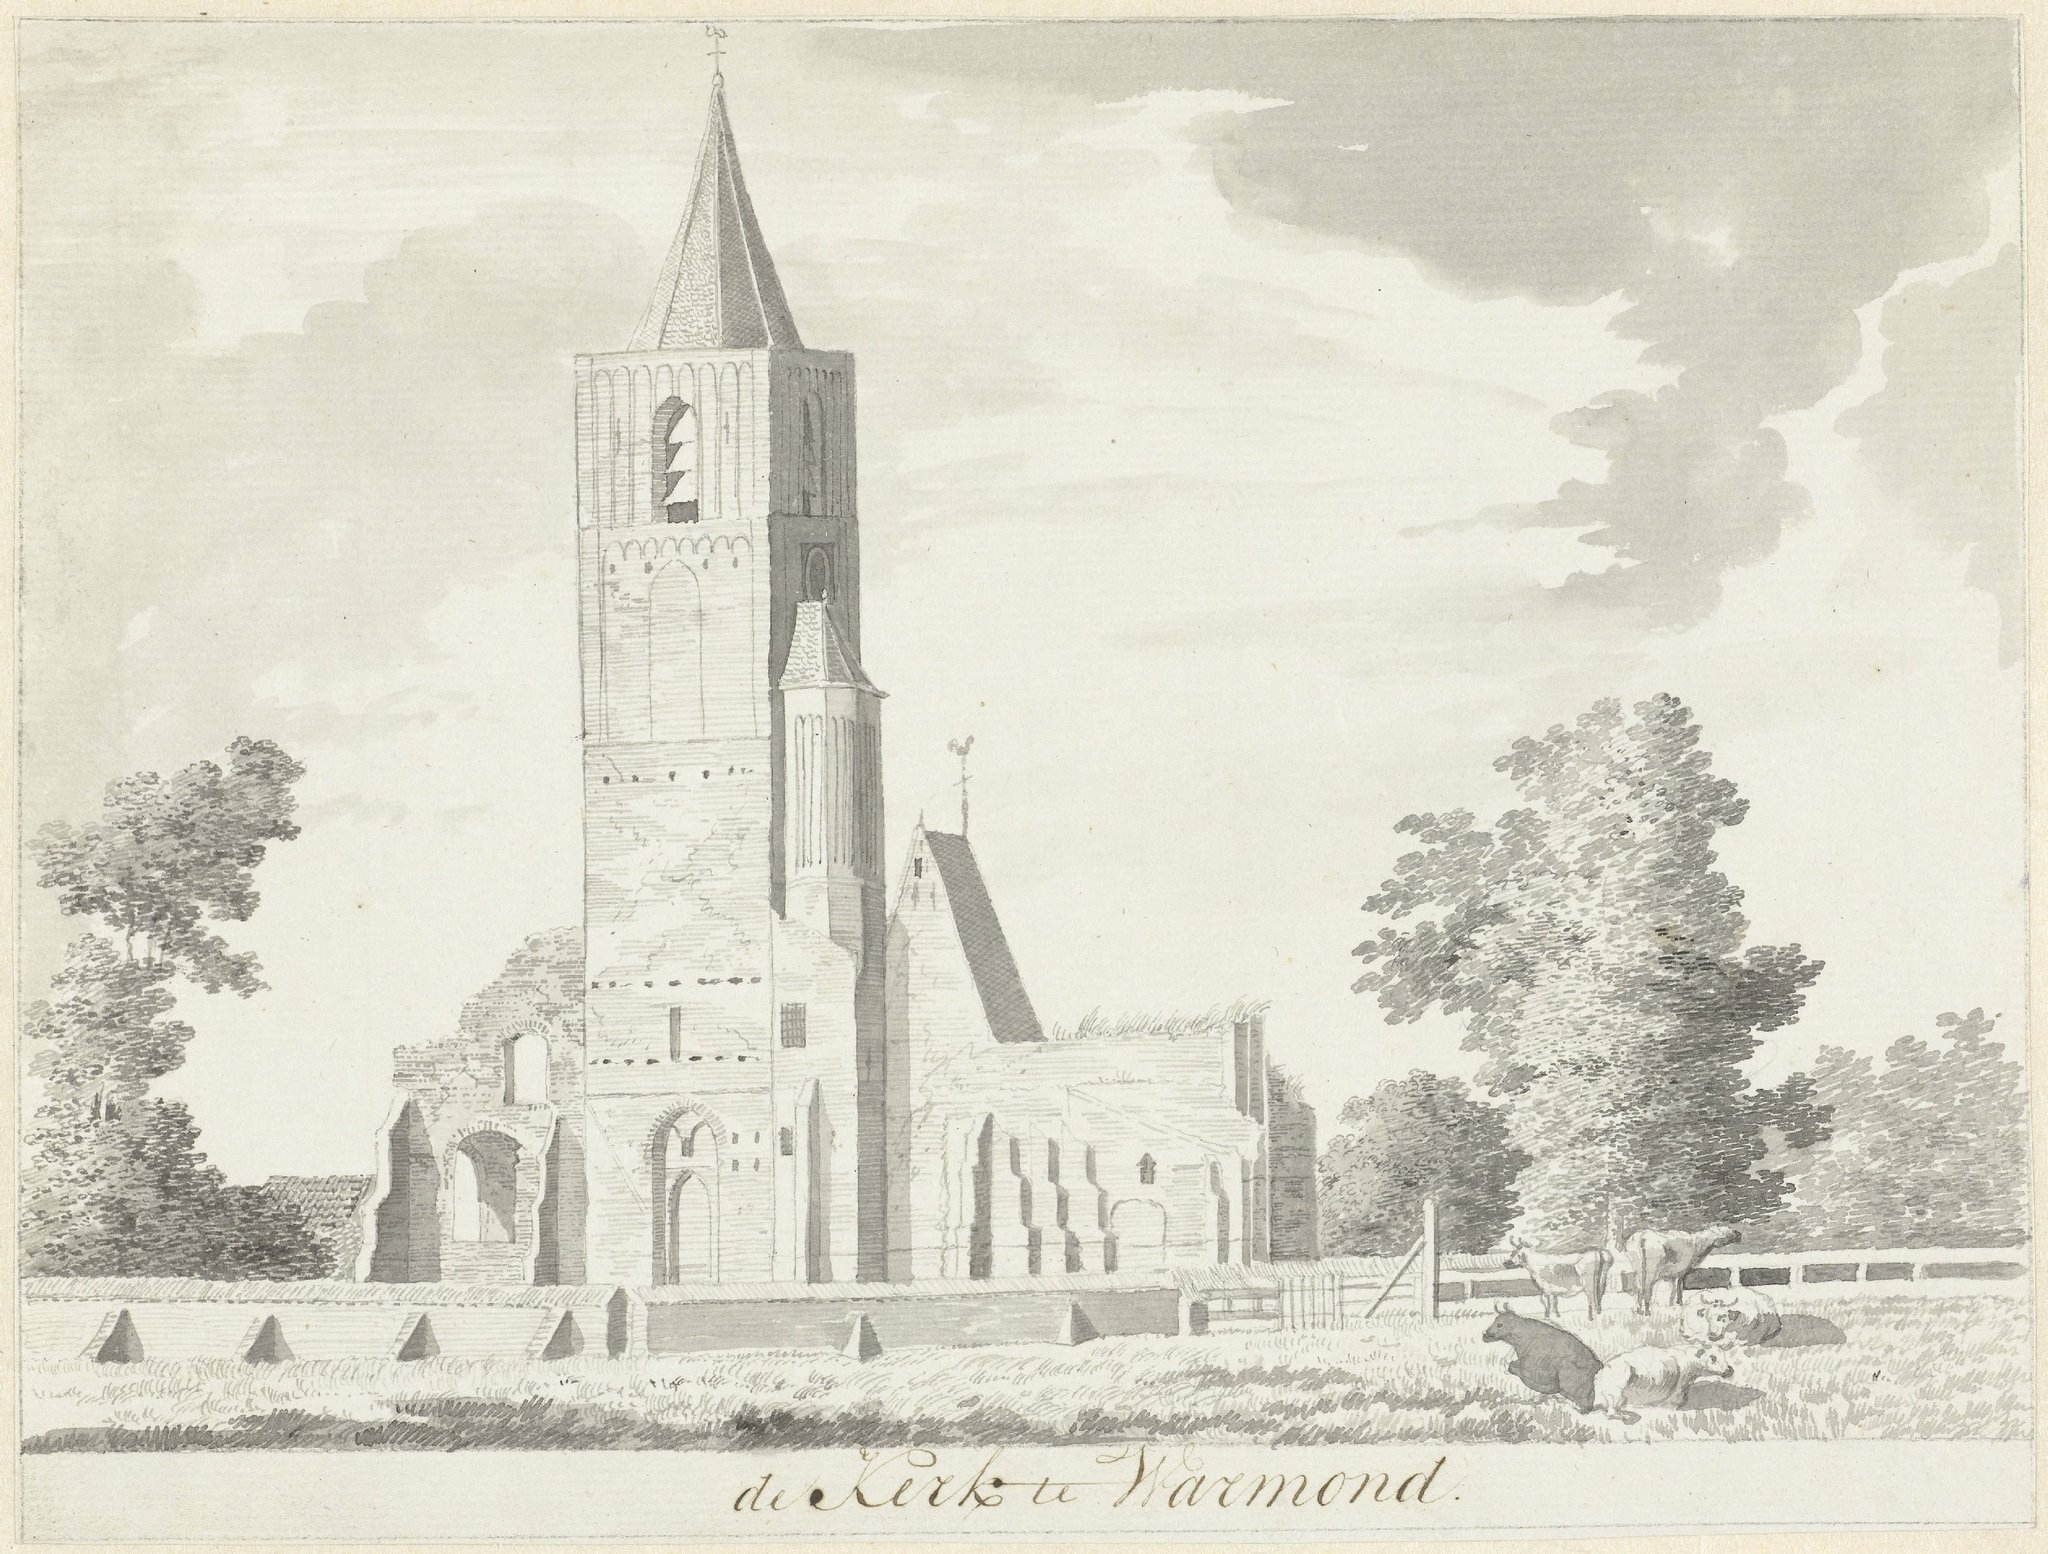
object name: drawing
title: Kerk te Warmond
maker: hendrik tavenier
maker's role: draughtsman, print maker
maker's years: 1734-1807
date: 1783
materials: ink, paper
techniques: brush, pen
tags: church (exterior), ruin of church, monastery, etc., warmond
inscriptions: inscription: ‘d kerk te Warmont 1783 / H. Tavenier’